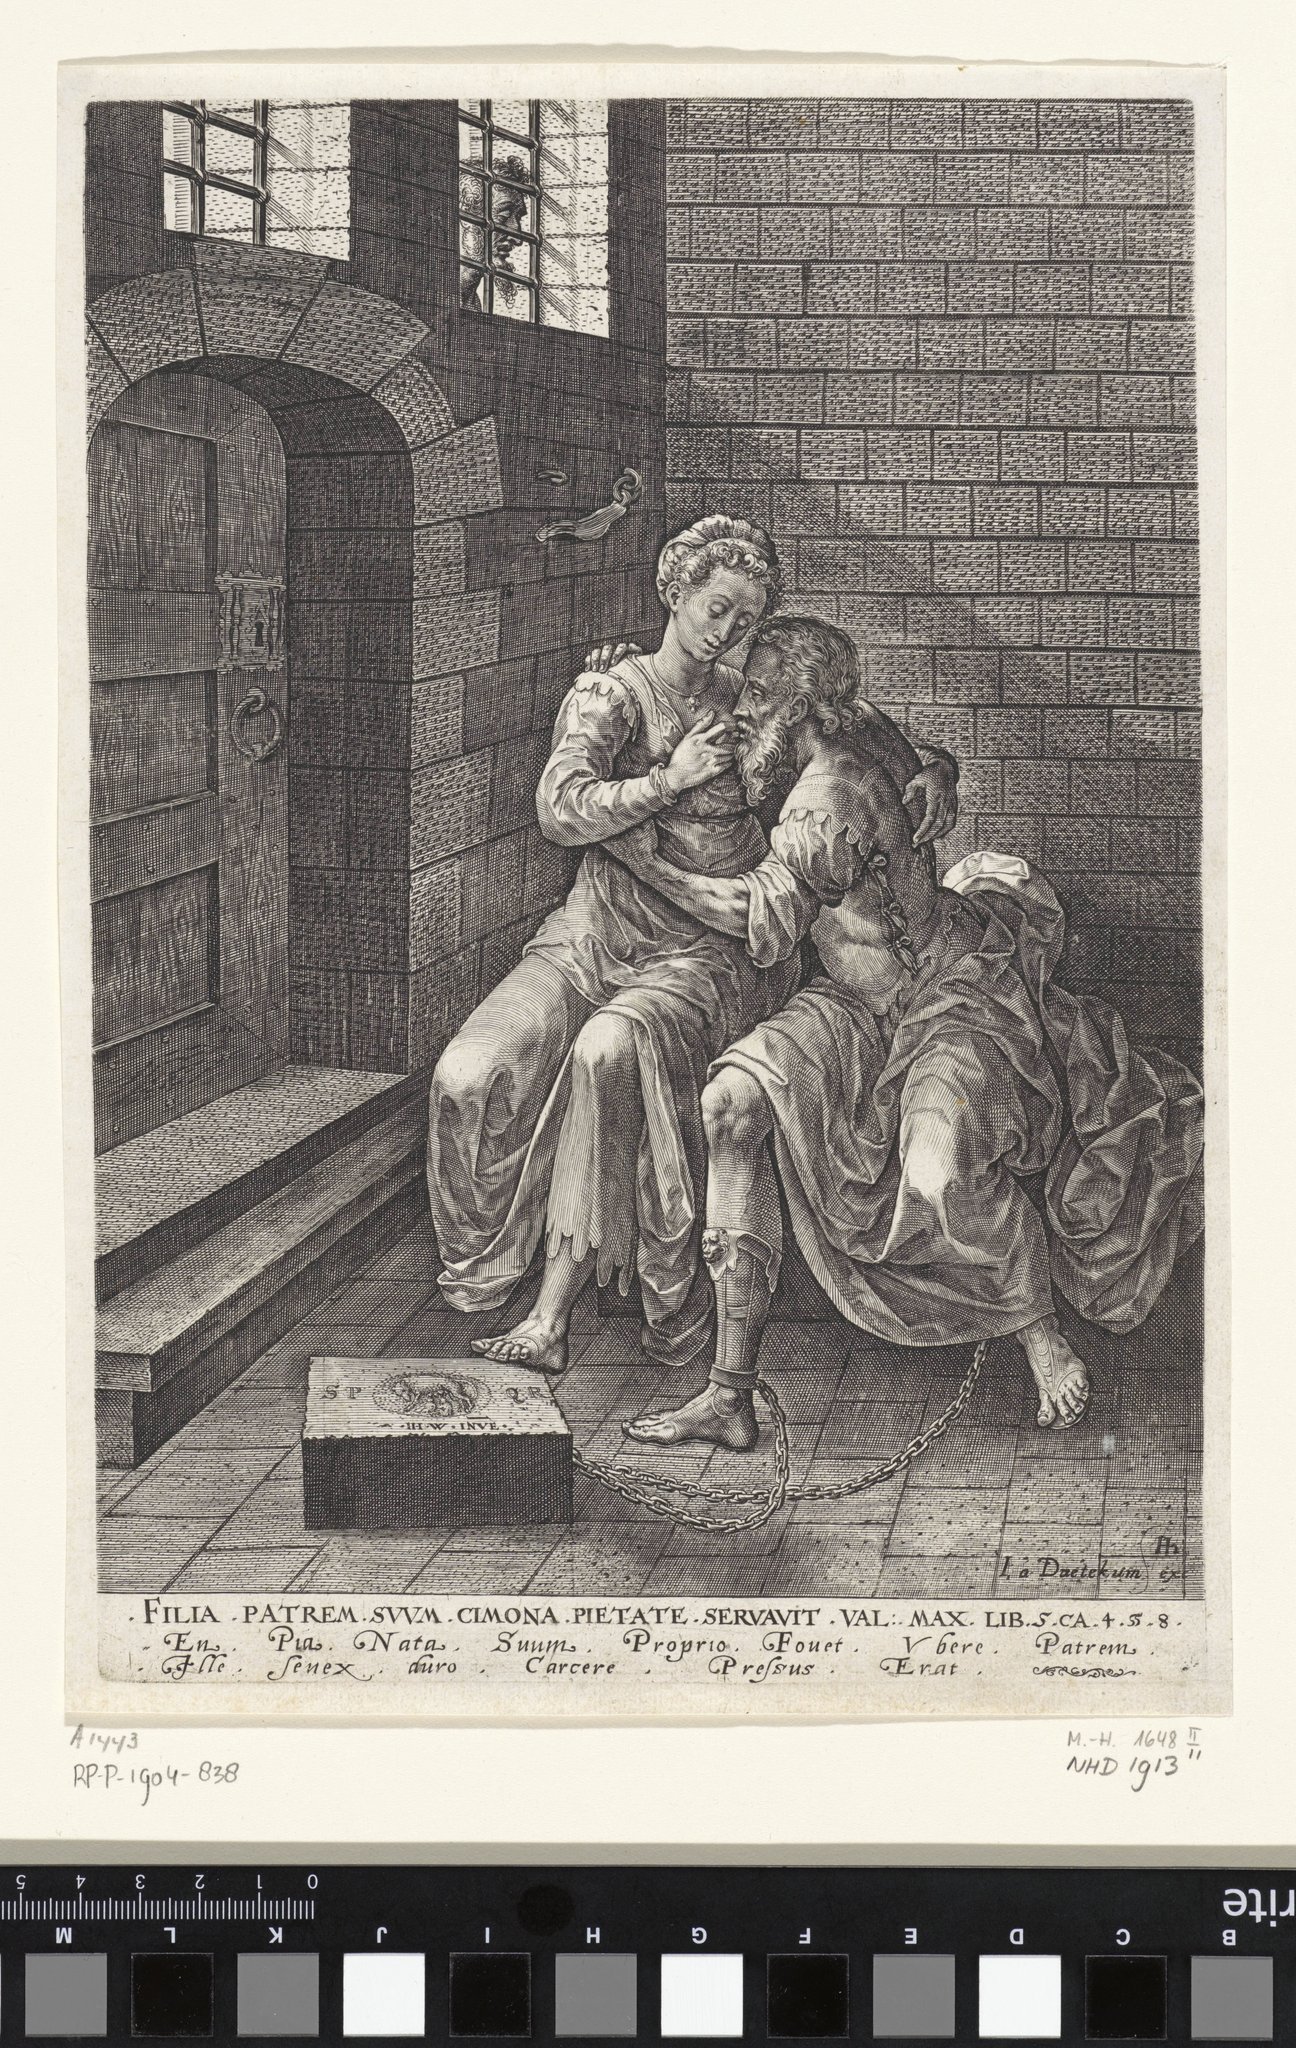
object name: print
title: Pero zoogt de geketende Cimon in de gevangenis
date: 1583-1650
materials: paper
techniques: engraving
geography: antwerp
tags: romulus and remus are washed ashore and suckled by a she-wolf; 'lupa romana', pero suckling cimon ('caritas romana')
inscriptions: collector's mark: Lugt 2228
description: Pero geeft haar vader Cimon de borst in zijn gevangeniscel (Caritas Romana). Cimon is vastgeketend aan een steen waarop de wolvin met Remus en Romulus is afgebeeld. Door de tralies kijkt een man stiekem toe. Het verhaal is een voorbeeld uit de klassieke literatuur van de liefde van kinderen voor hun ouders. In de marge een drieregelig onderschrift in het Latijn.